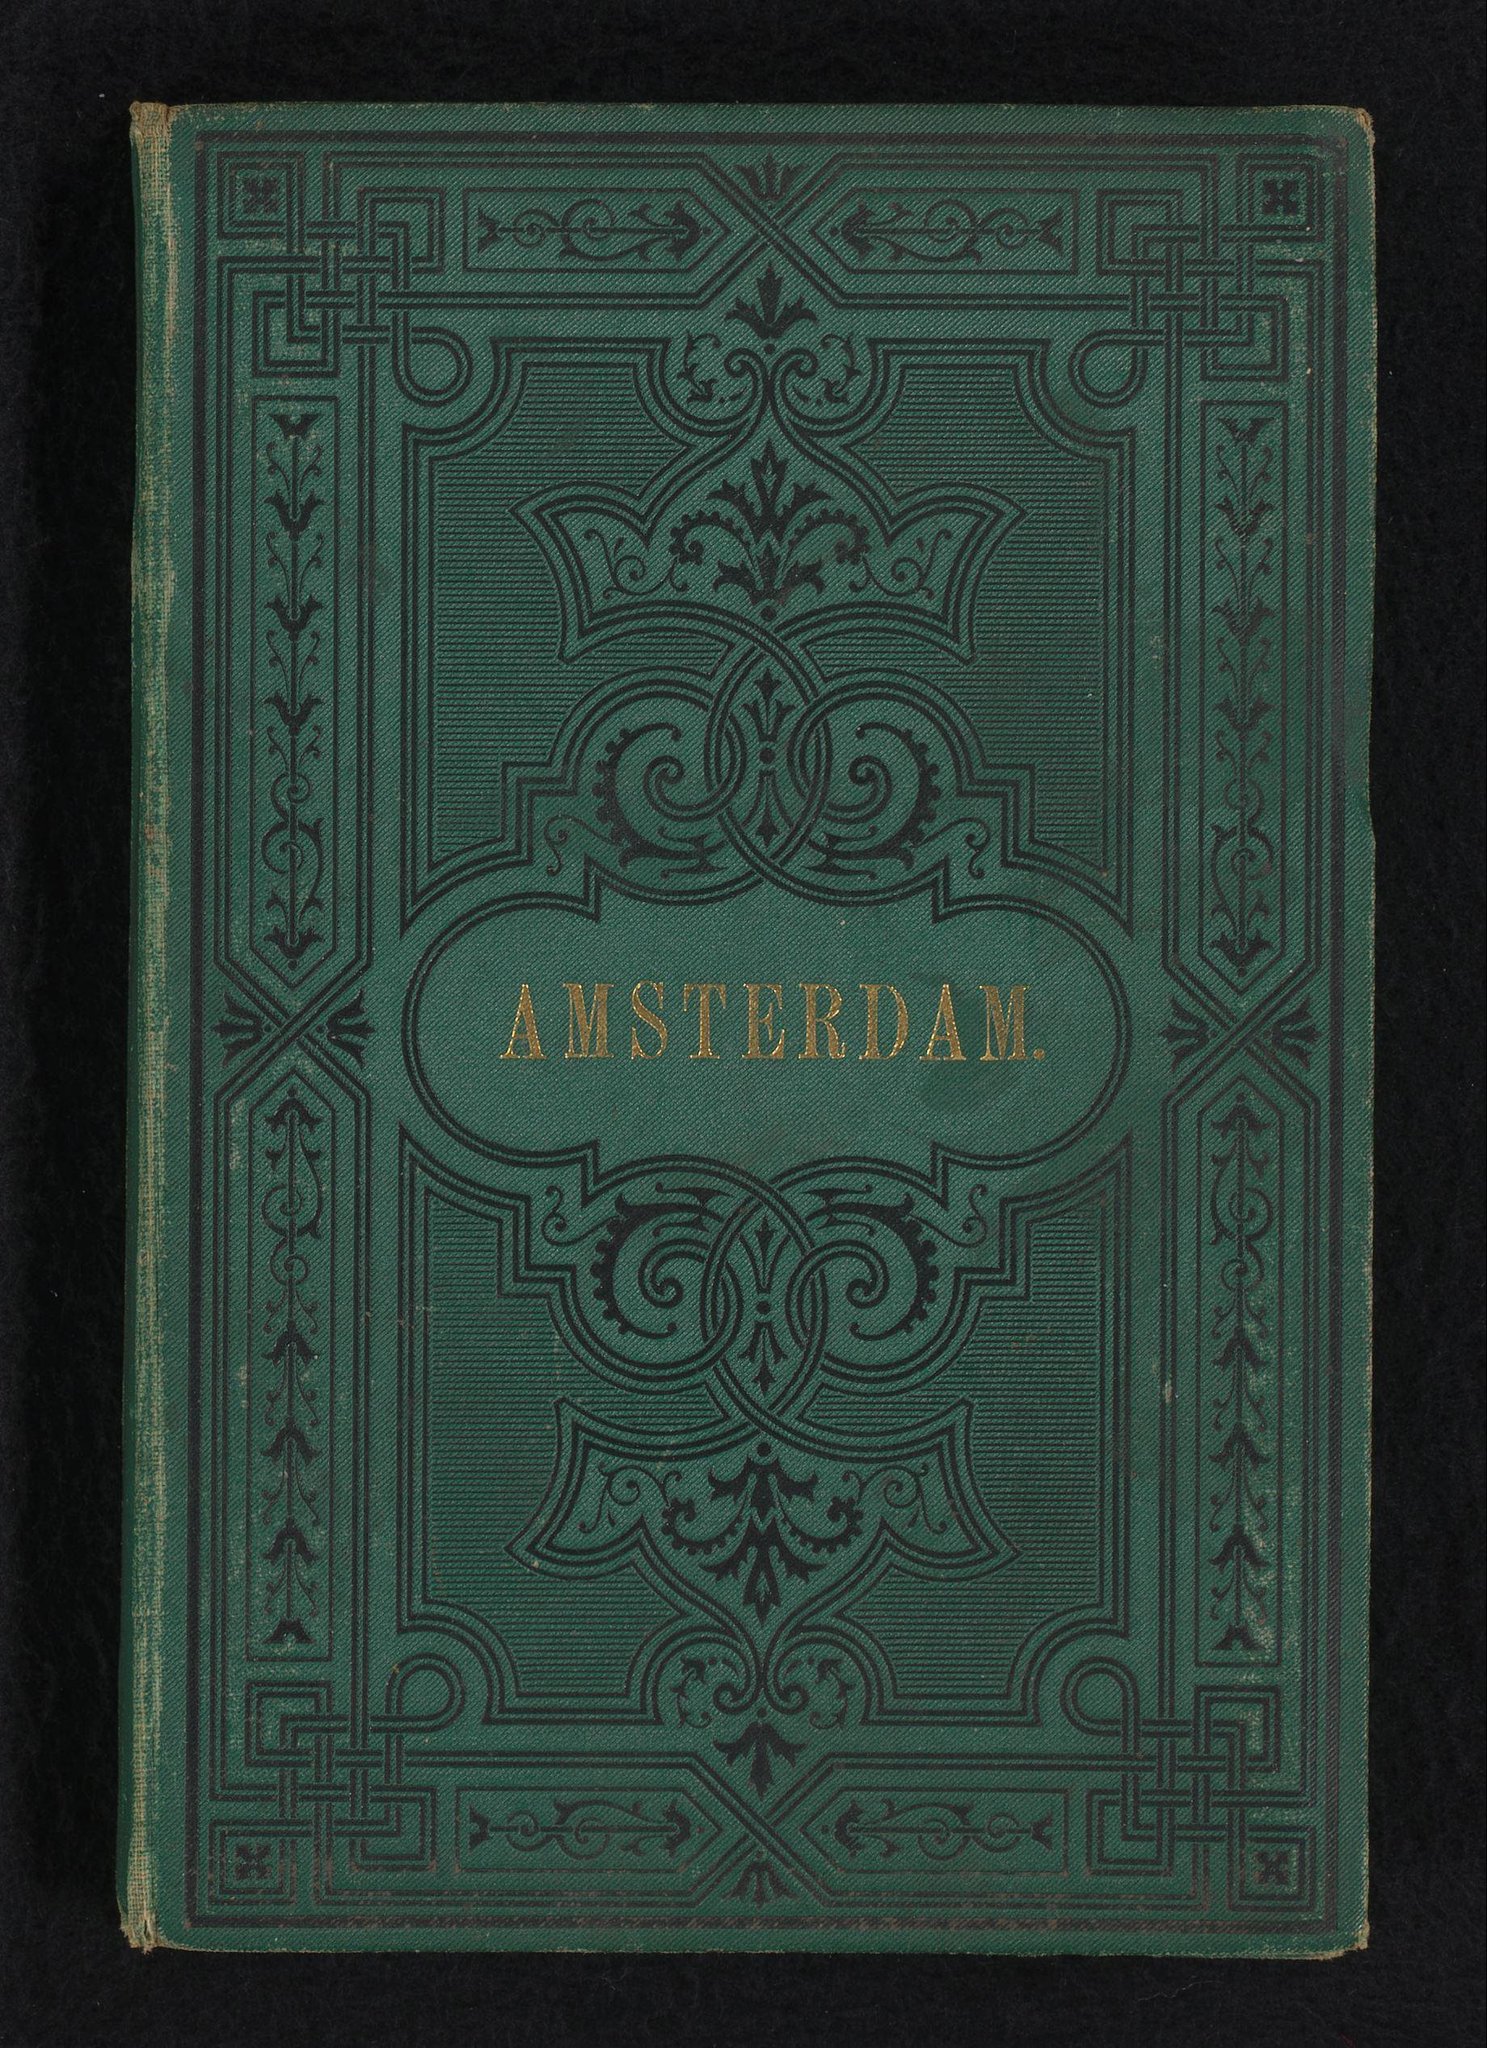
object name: accordion book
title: Amsterdam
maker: andries jager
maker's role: publisher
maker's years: 1825-1905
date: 1870-1900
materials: cardboard, linen, paper, photographic support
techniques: albumen print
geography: amsterdam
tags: city-view in general; 'veduta', amsterdam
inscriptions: collector's mark: ‘Dienst Verspreide Rijkskollekties (...) A921’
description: Leporelloalbum met twaalf stadsgezichten van Amsterdam. Het album bevat twaalf aan elkaar vastzittende, kartonnen bladen met foto's. De bladen zijn als een harmonica uitklapbaar naar twee kanten. Onder andere te zien zijn het Amstel Hotel, het paleis op de Dam en de Waag.